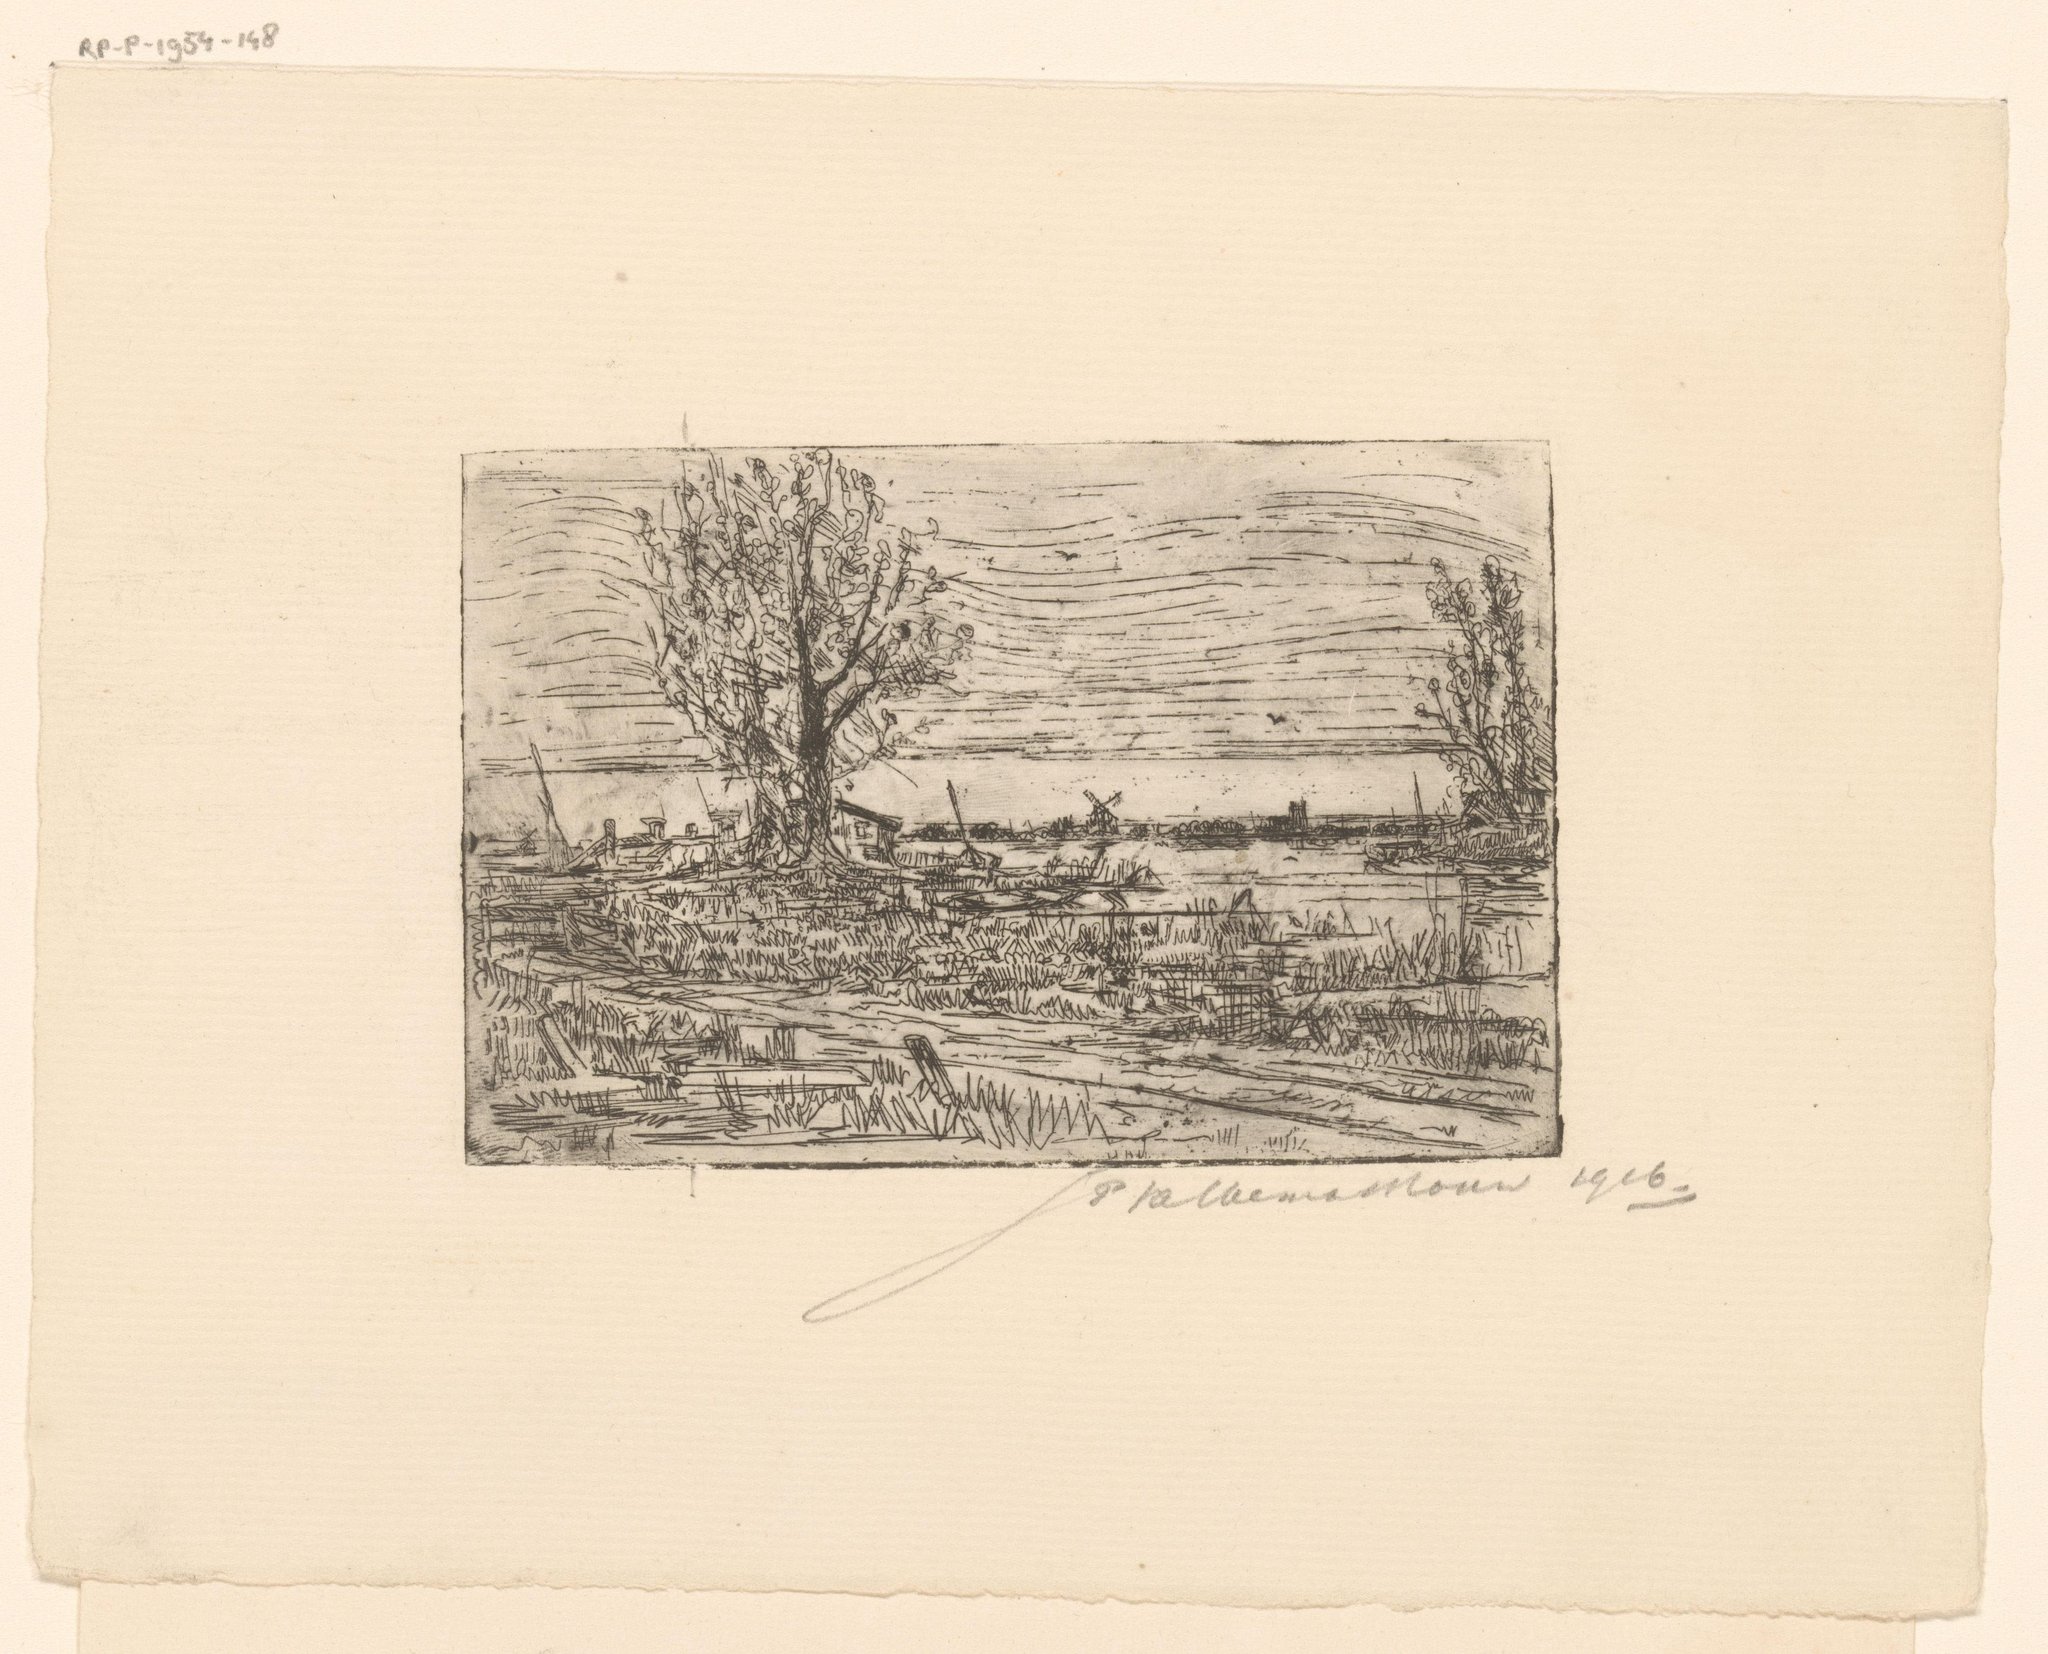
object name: print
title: Landweg langs een plas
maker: jan paul valkema blouw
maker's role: draughtsman, print maker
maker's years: 1884-1954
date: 1916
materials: paper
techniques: etching, intaglio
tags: meadow, pasture, lake, road, path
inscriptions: collector's mark: Lugt 2760, collector's mark: Lugt 2228